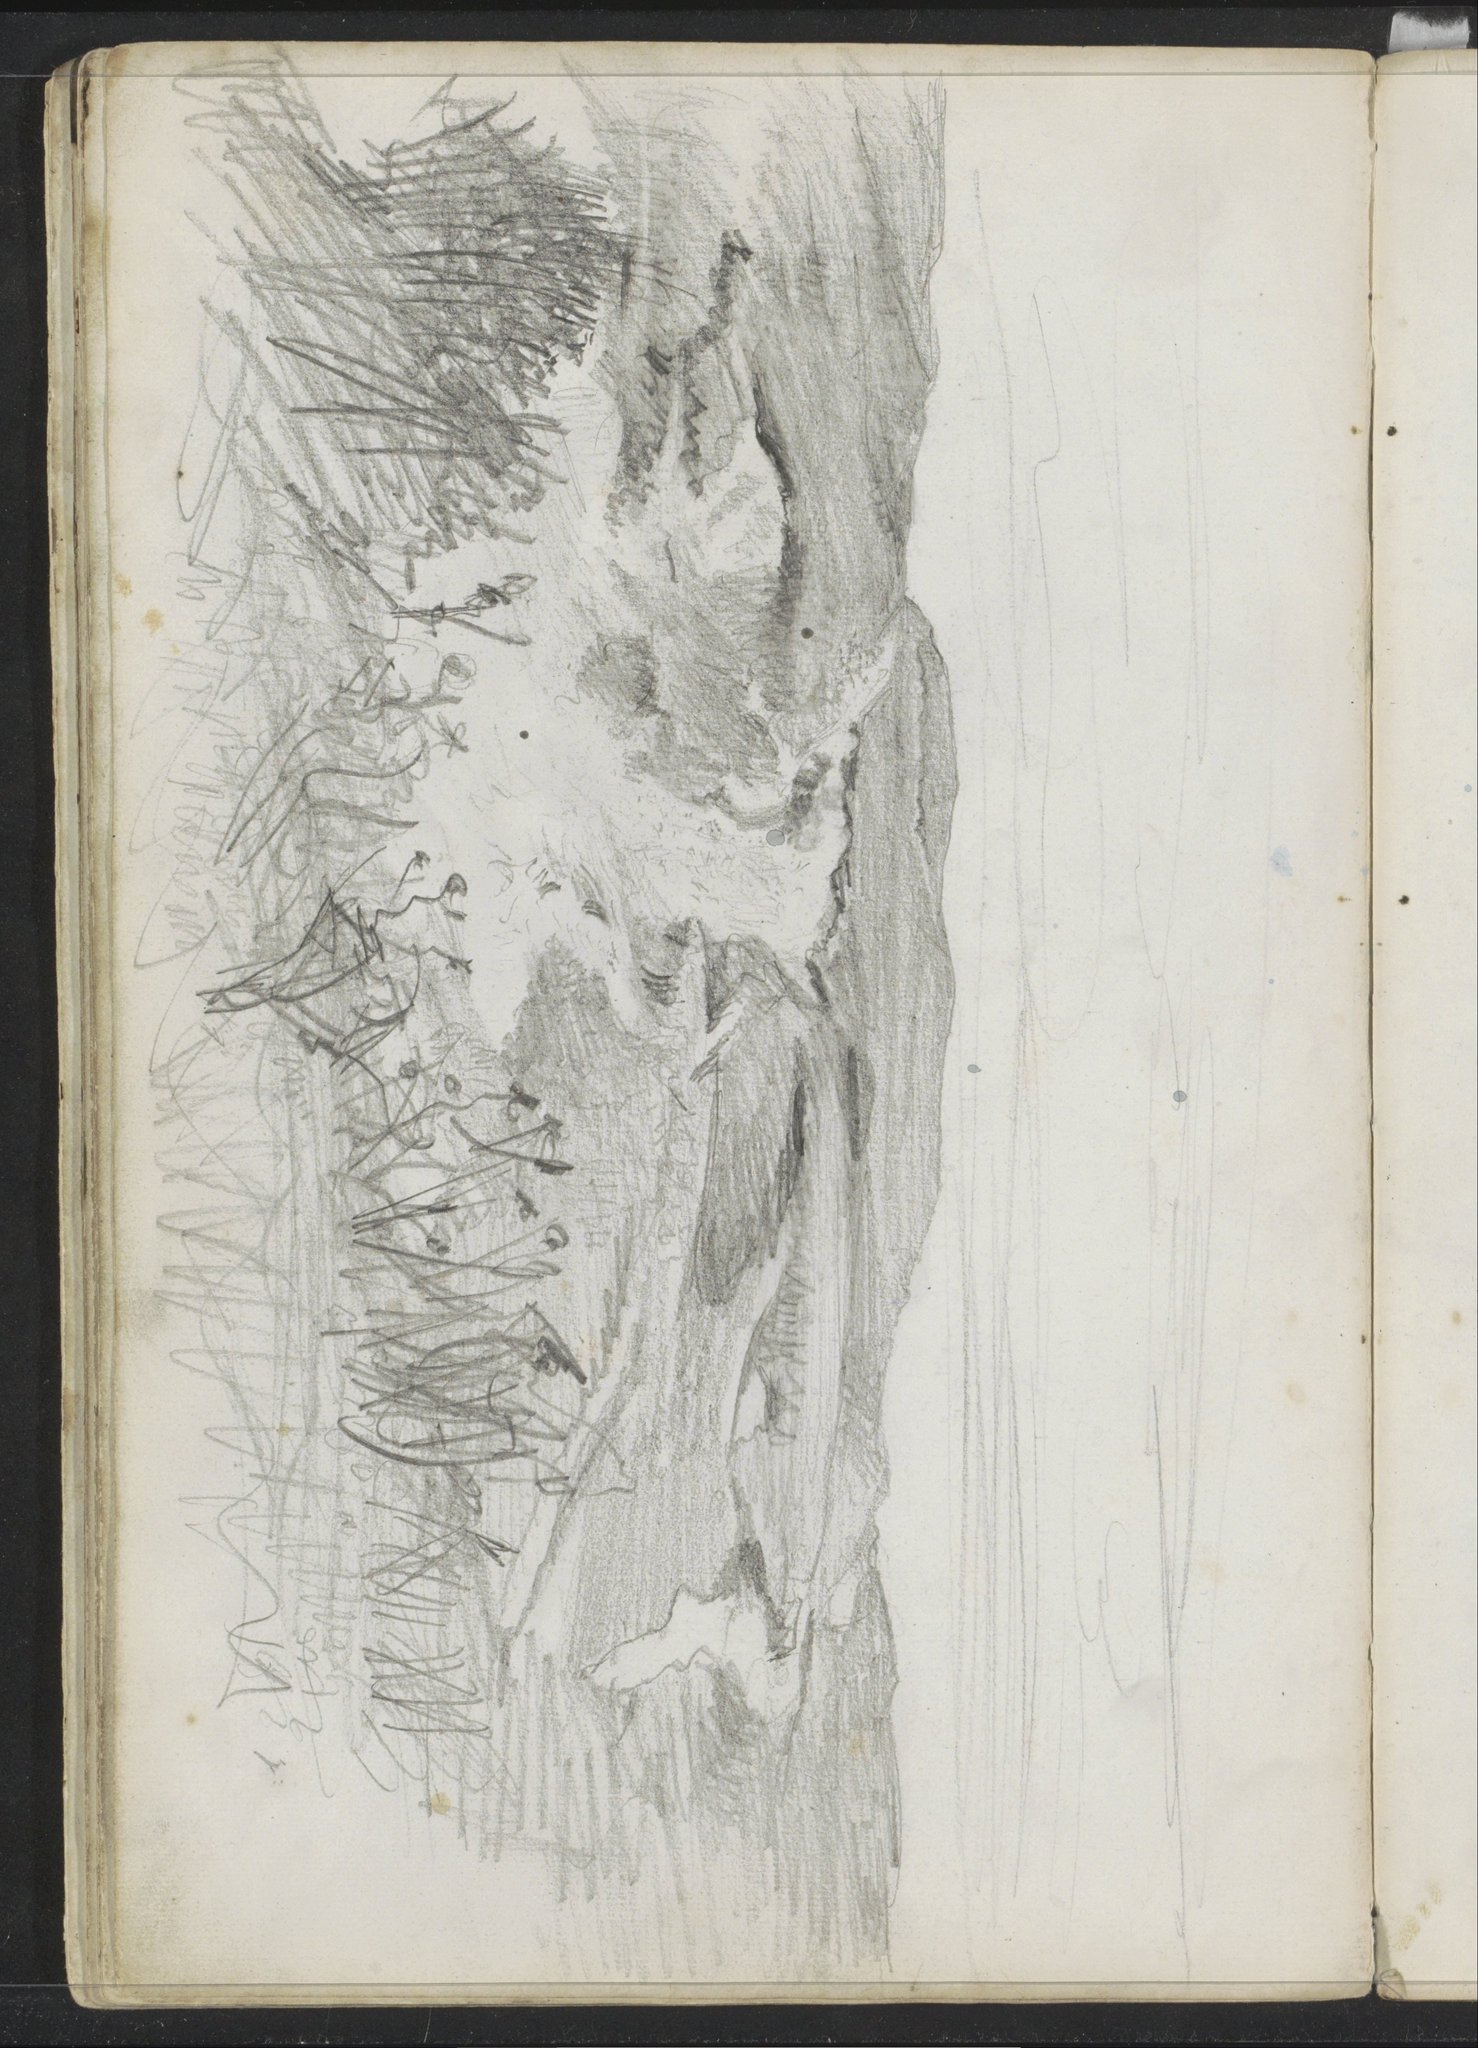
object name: sketchbook leaf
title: Duinlandschap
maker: jozef israëls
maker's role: draughtsman, painter, print maker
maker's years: 1824-1911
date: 1855-1859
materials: paper, pencil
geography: zandvoort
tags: dune coast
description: Blad 17 verso uit een schetsboek met 22 bladen.